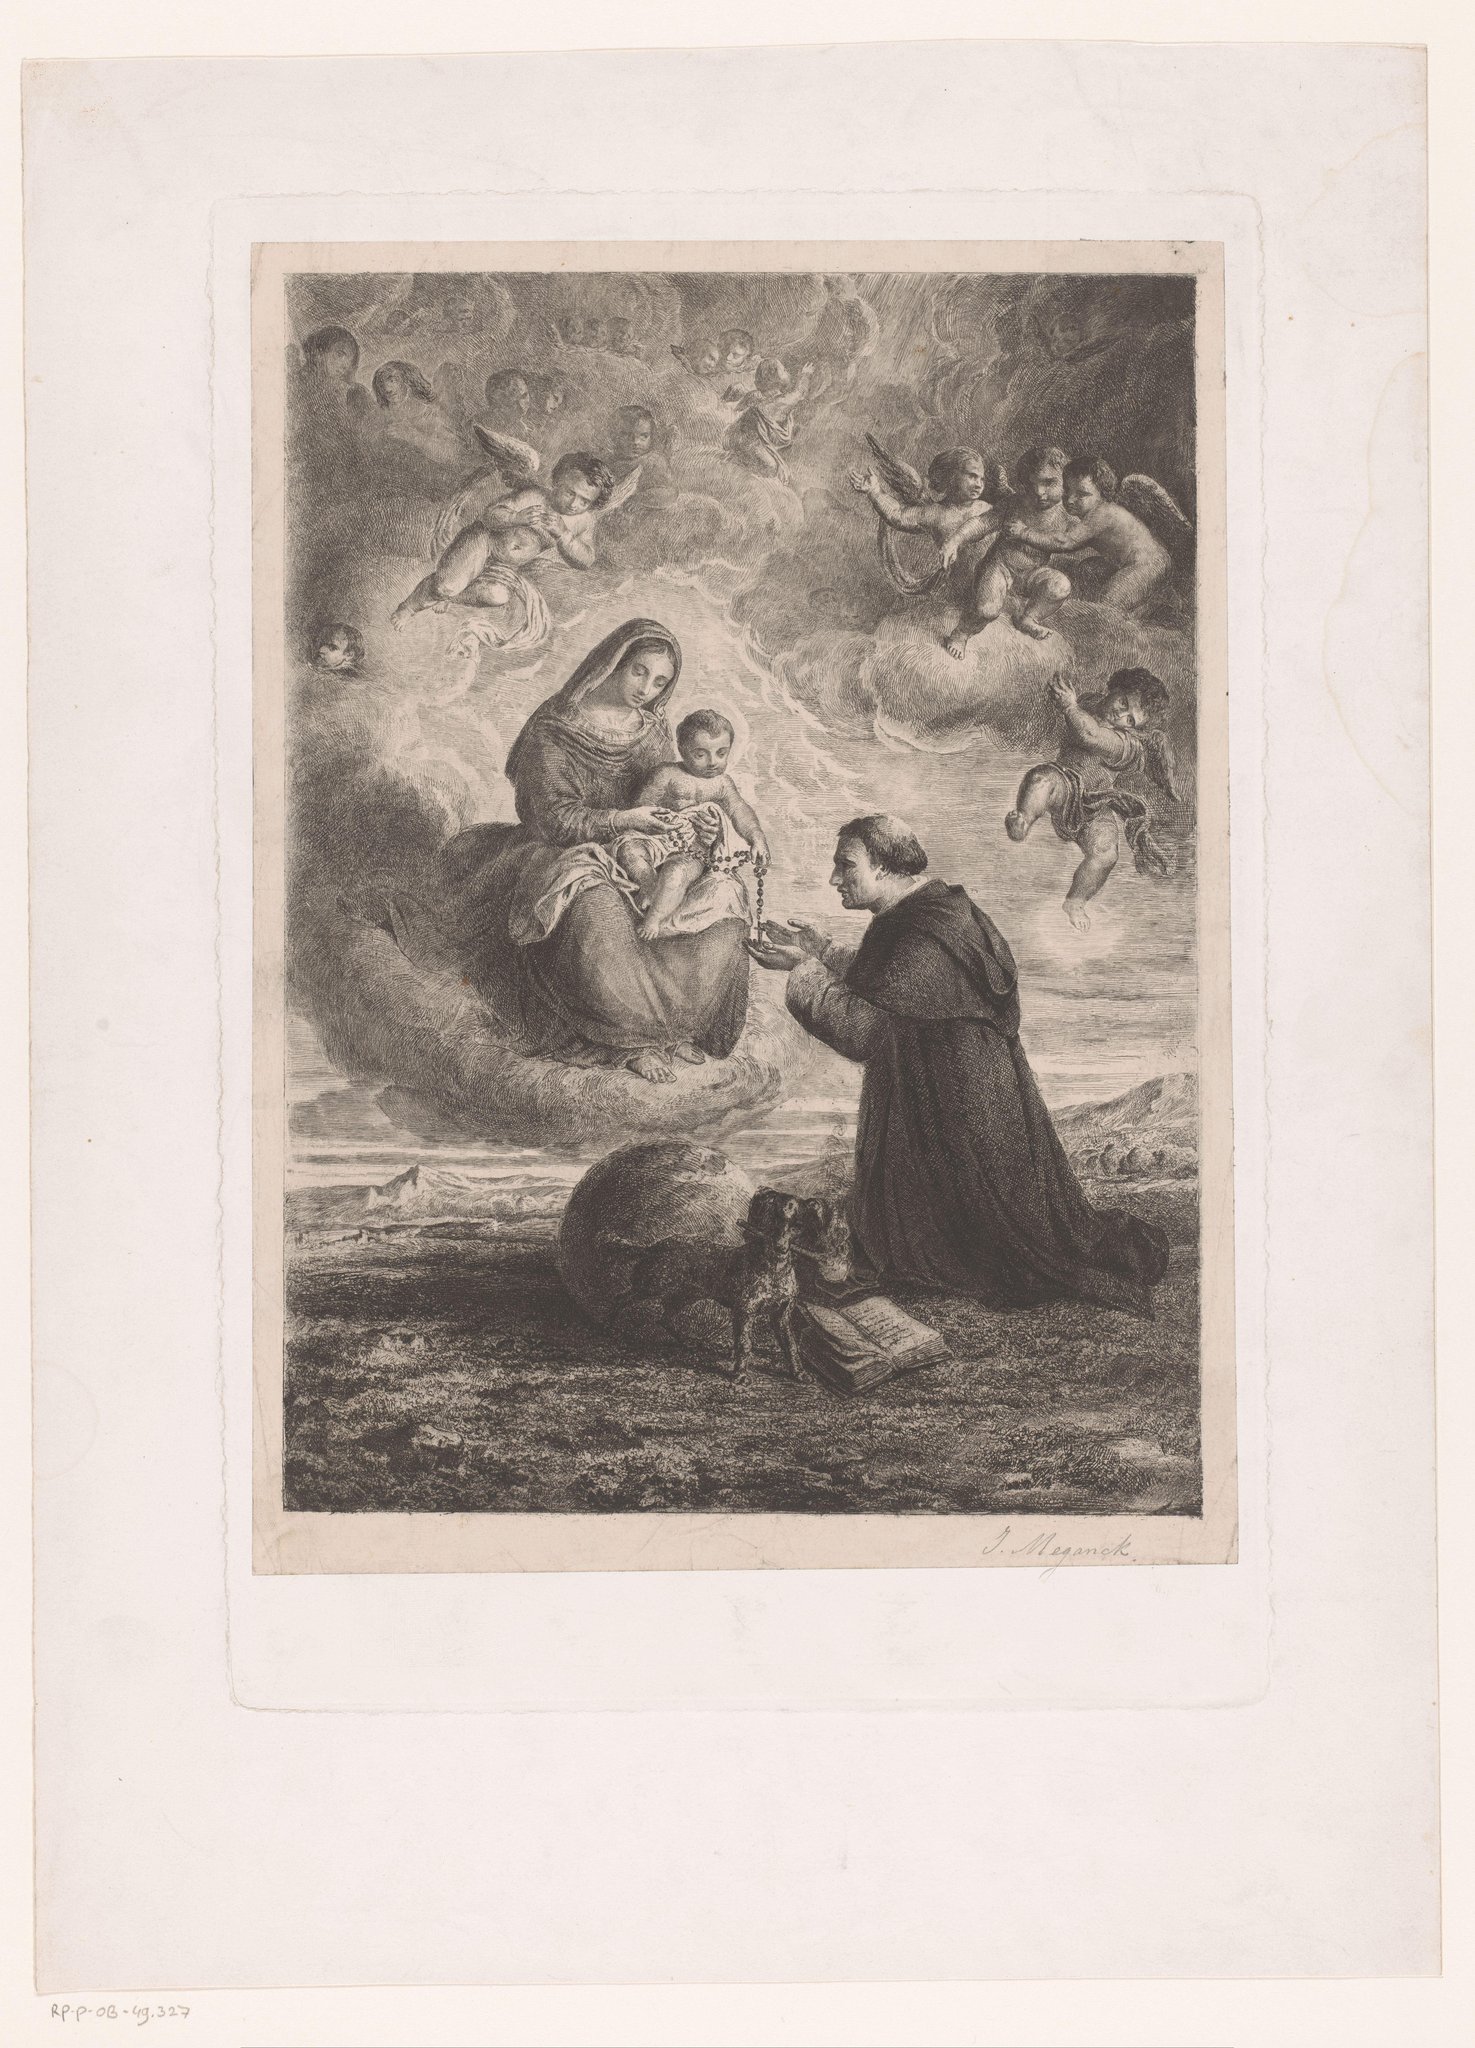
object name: print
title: Verschijning van Maria met het Christuskind aan Sint-Dominicus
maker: joseph meganck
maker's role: print maker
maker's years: 1807-1891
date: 1817-1891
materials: paper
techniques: etching, intaglio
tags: dominic(us) guzman of calerueja, founder of the order of preachers (or dominican (black) friars; possible attributes: book, dog with flaming torch, lily, loaf of bread, rosary, star, the virgin mary (or the infant christ in her lap) hands over a rosary to st. dominic, who kneels before her; usually st. catharine of siena is also present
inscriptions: collector's mark: Lugt 2228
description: Christus geeft een rozenkrans aan Dominicus.